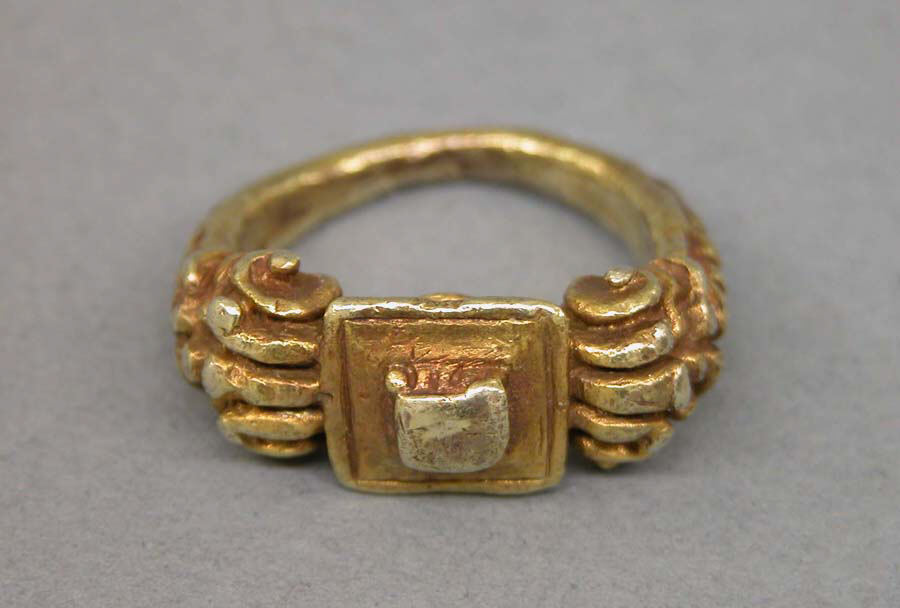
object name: ring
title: Stirrup-shaped Ring with Square Bezel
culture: indonesian, javanese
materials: gold